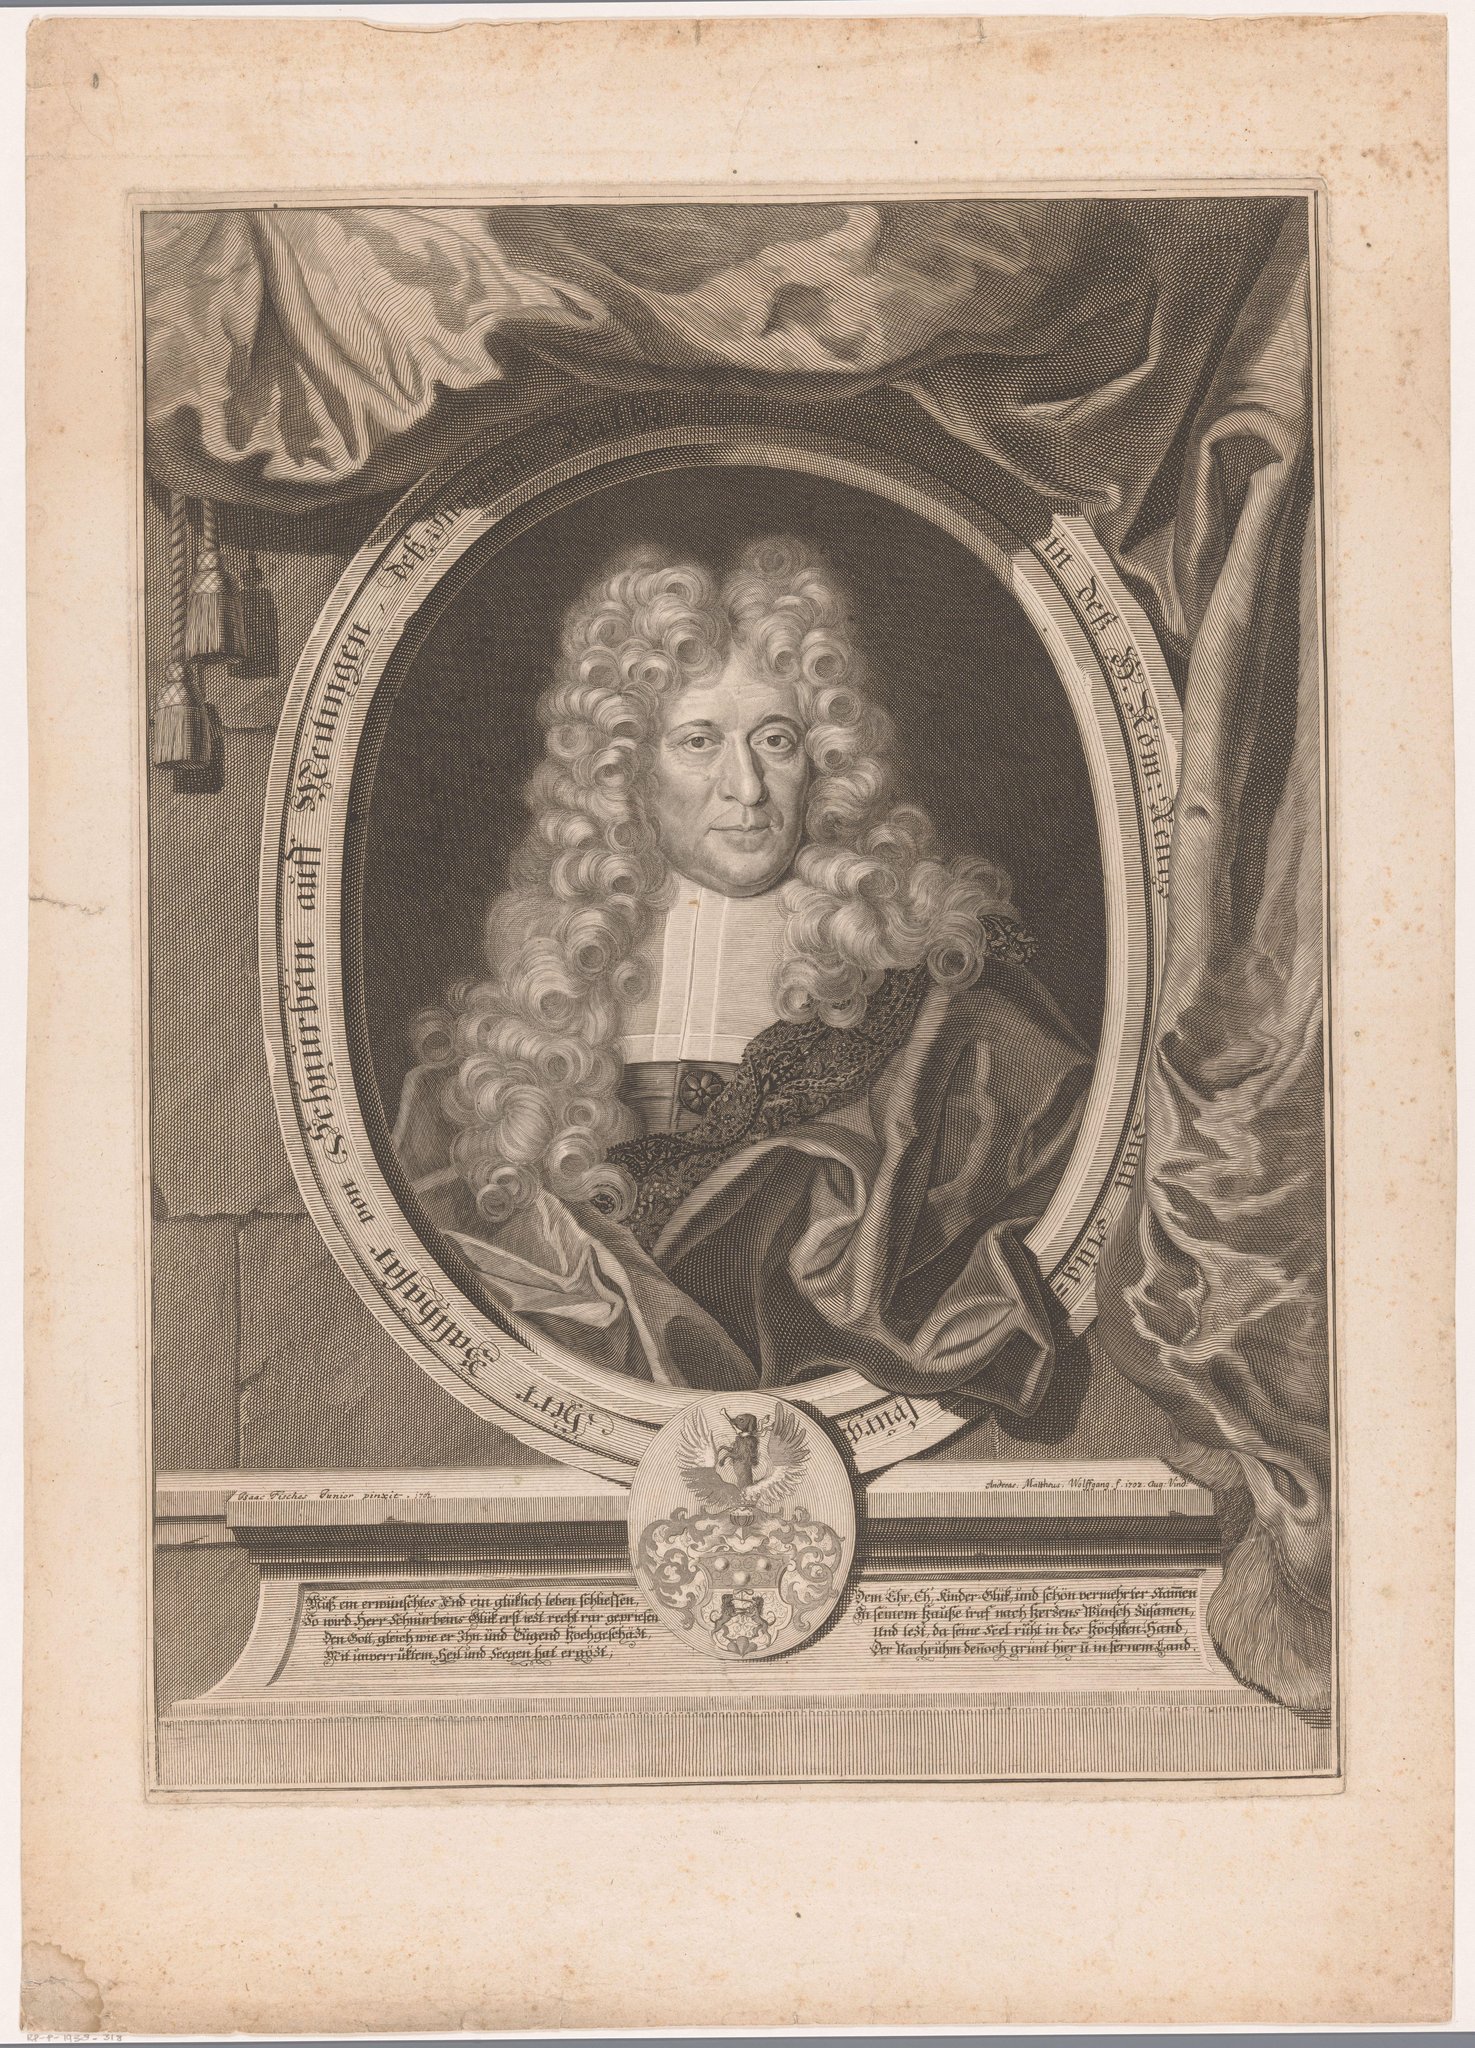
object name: print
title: Portret van Balthasar III Schnurbein von Meitingen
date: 1702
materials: paper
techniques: engraving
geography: augsburg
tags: historical persons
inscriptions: collector's mark: Lugt 2228